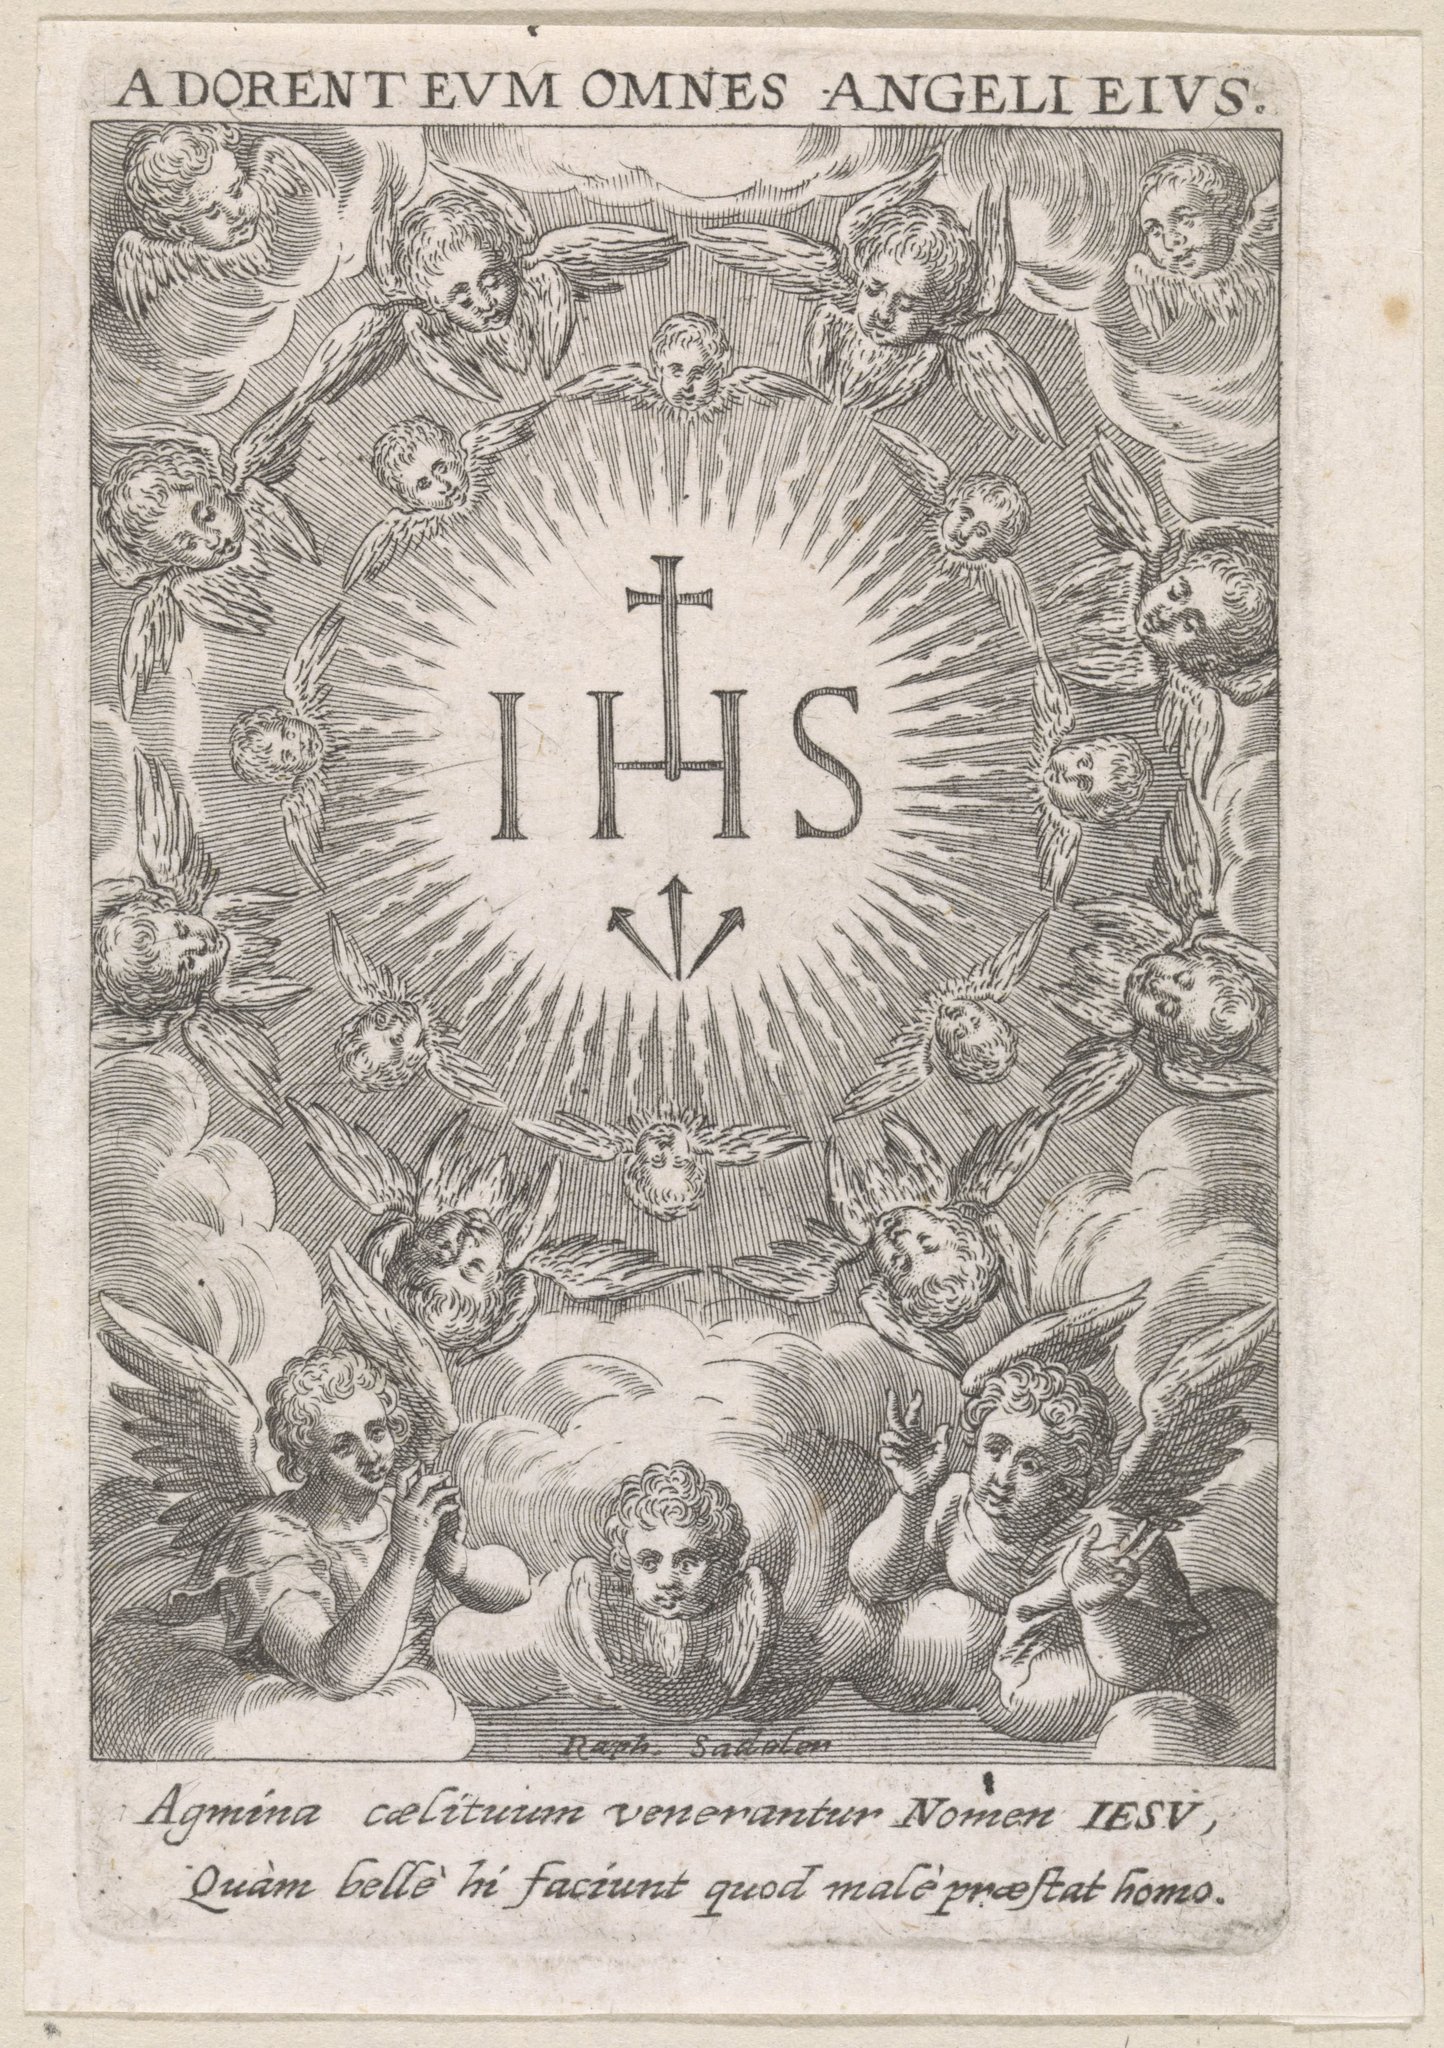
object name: book illustration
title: Christusmonogram omringd door cherubijnen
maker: anna bergia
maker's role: publisher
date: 1617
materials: paper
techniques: engraving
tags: ihs ('iesus hominum salvator') ~ symbol of christ (+ angel(s))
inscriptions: collector's mark: Lugt 240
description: Prent uit: Ceschi, Matia. Otium spirituale mellifluarum precationum. München: Anna Bergia en Raphaël Sadeler (I) of (II), 1617.